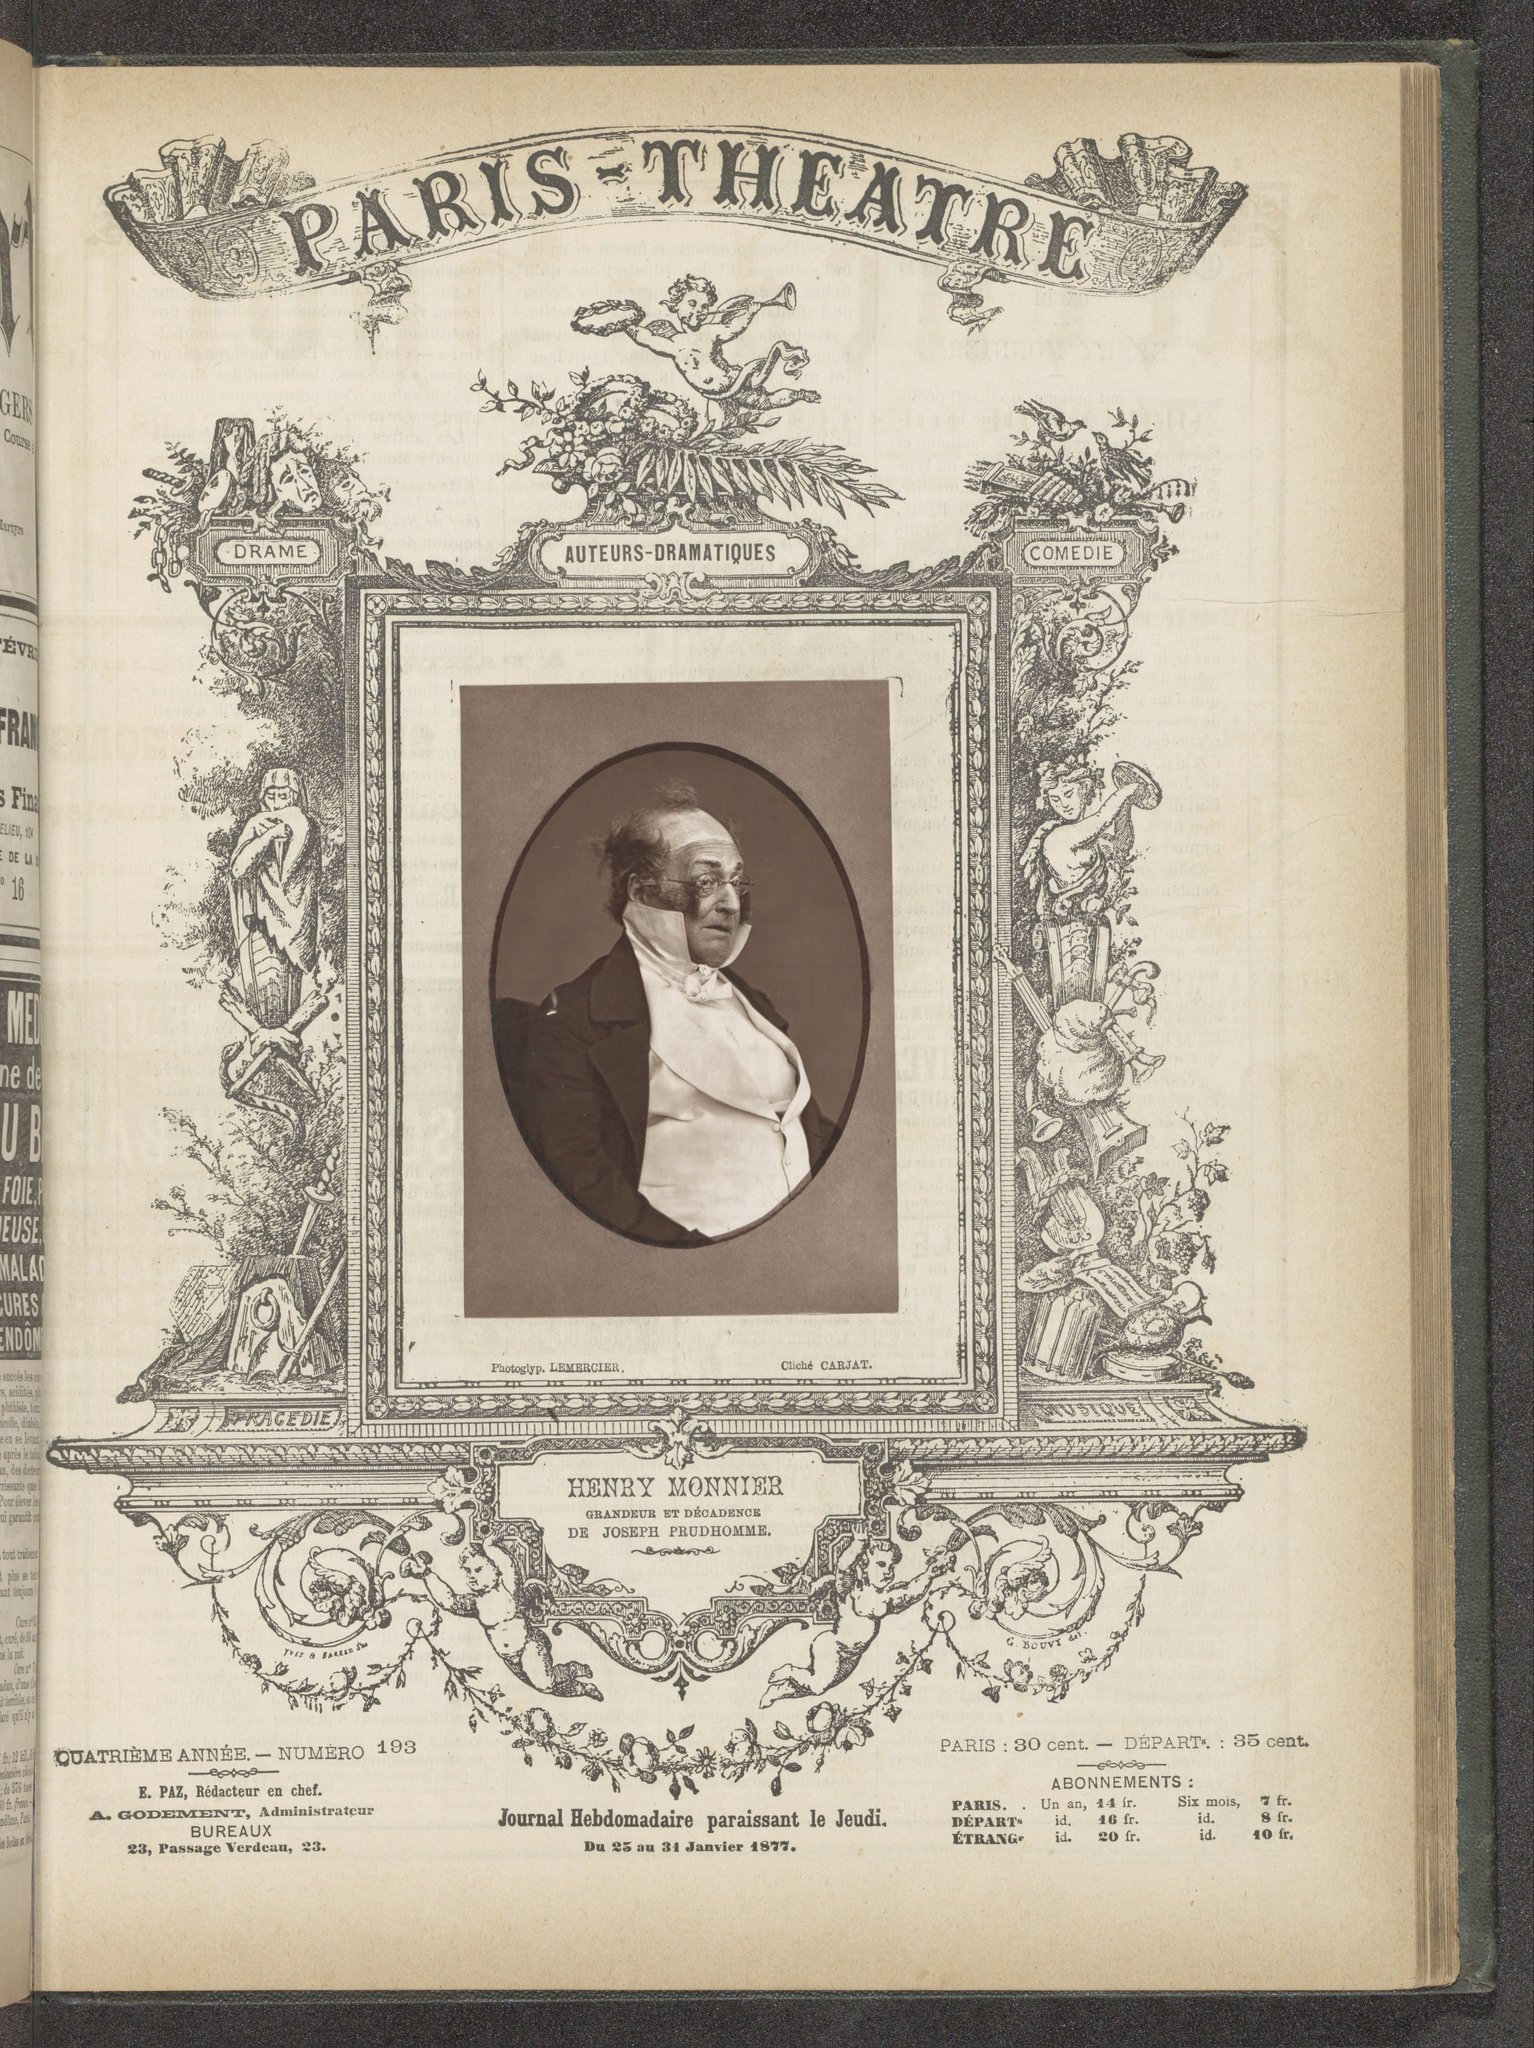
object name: photomechanical print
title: Henry Monnier grandeur et décadence de Joseph Prudhomme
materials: paper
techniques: woodburytype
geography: france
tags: print maker, draughtsman, henry bonaventure monnier, portrait of actor, actress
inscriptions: number: ‘Numéro 193’, inscription: ‘Journal Hebdomadaire paraissant le Jeudi, Du 25 au 31 Janvier 1877.’